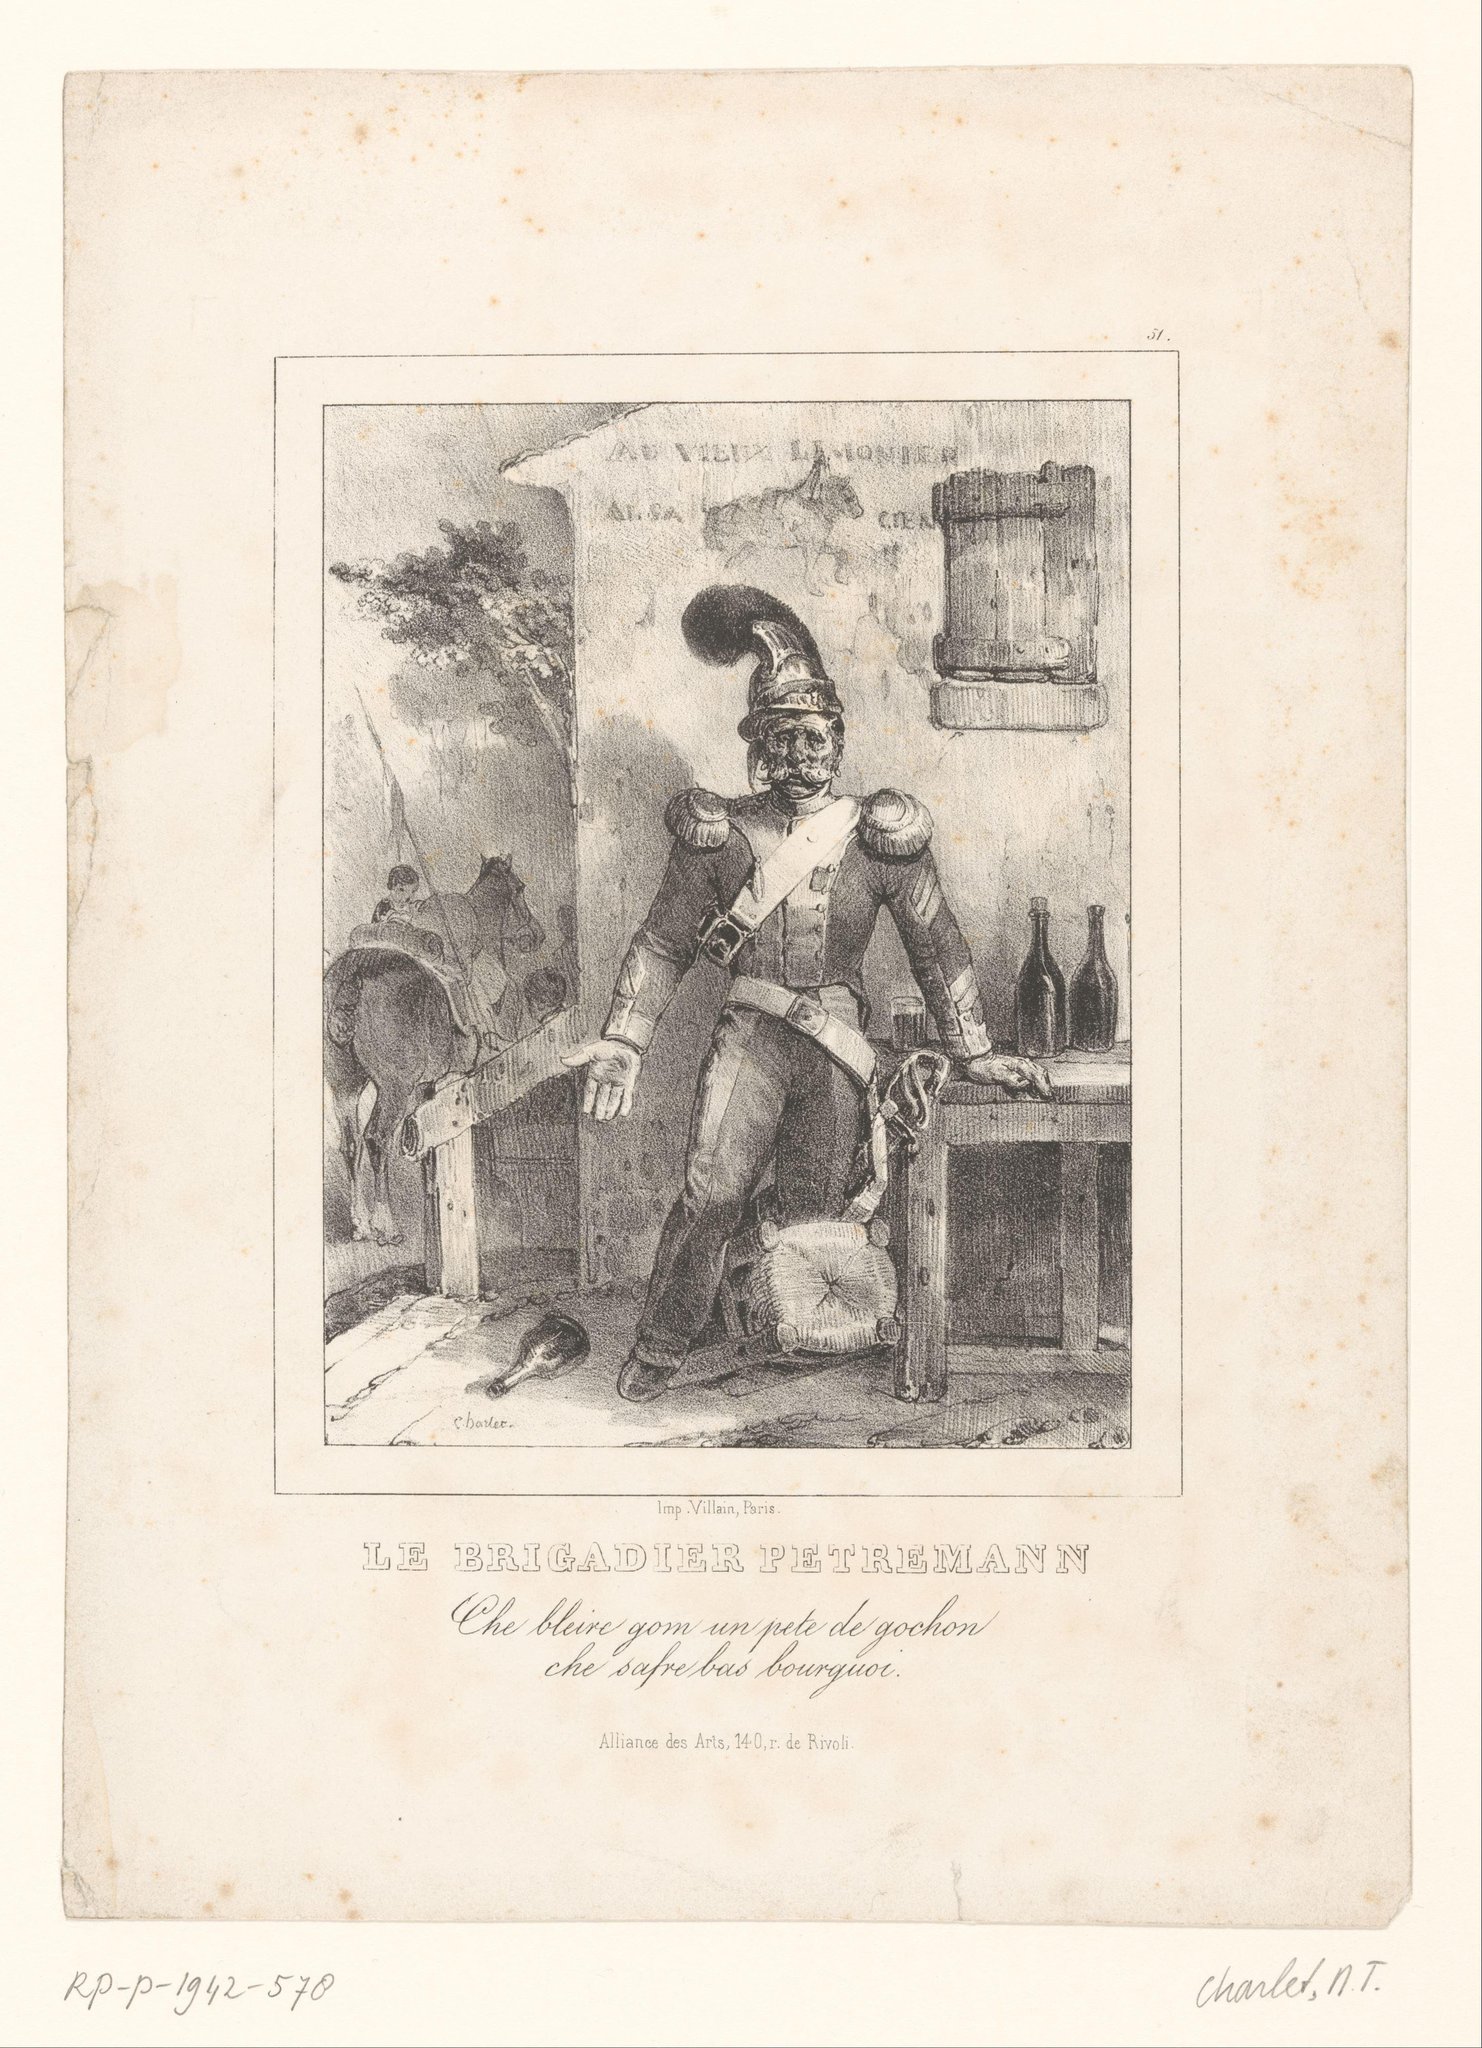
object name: print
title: Le brigadier Petremann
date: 1842-1847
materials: paper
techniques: lithograph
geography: paris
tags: canteen ~ the soldier off duty, drunkard, private soldier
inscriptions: collector's mark: Lugt 2228a